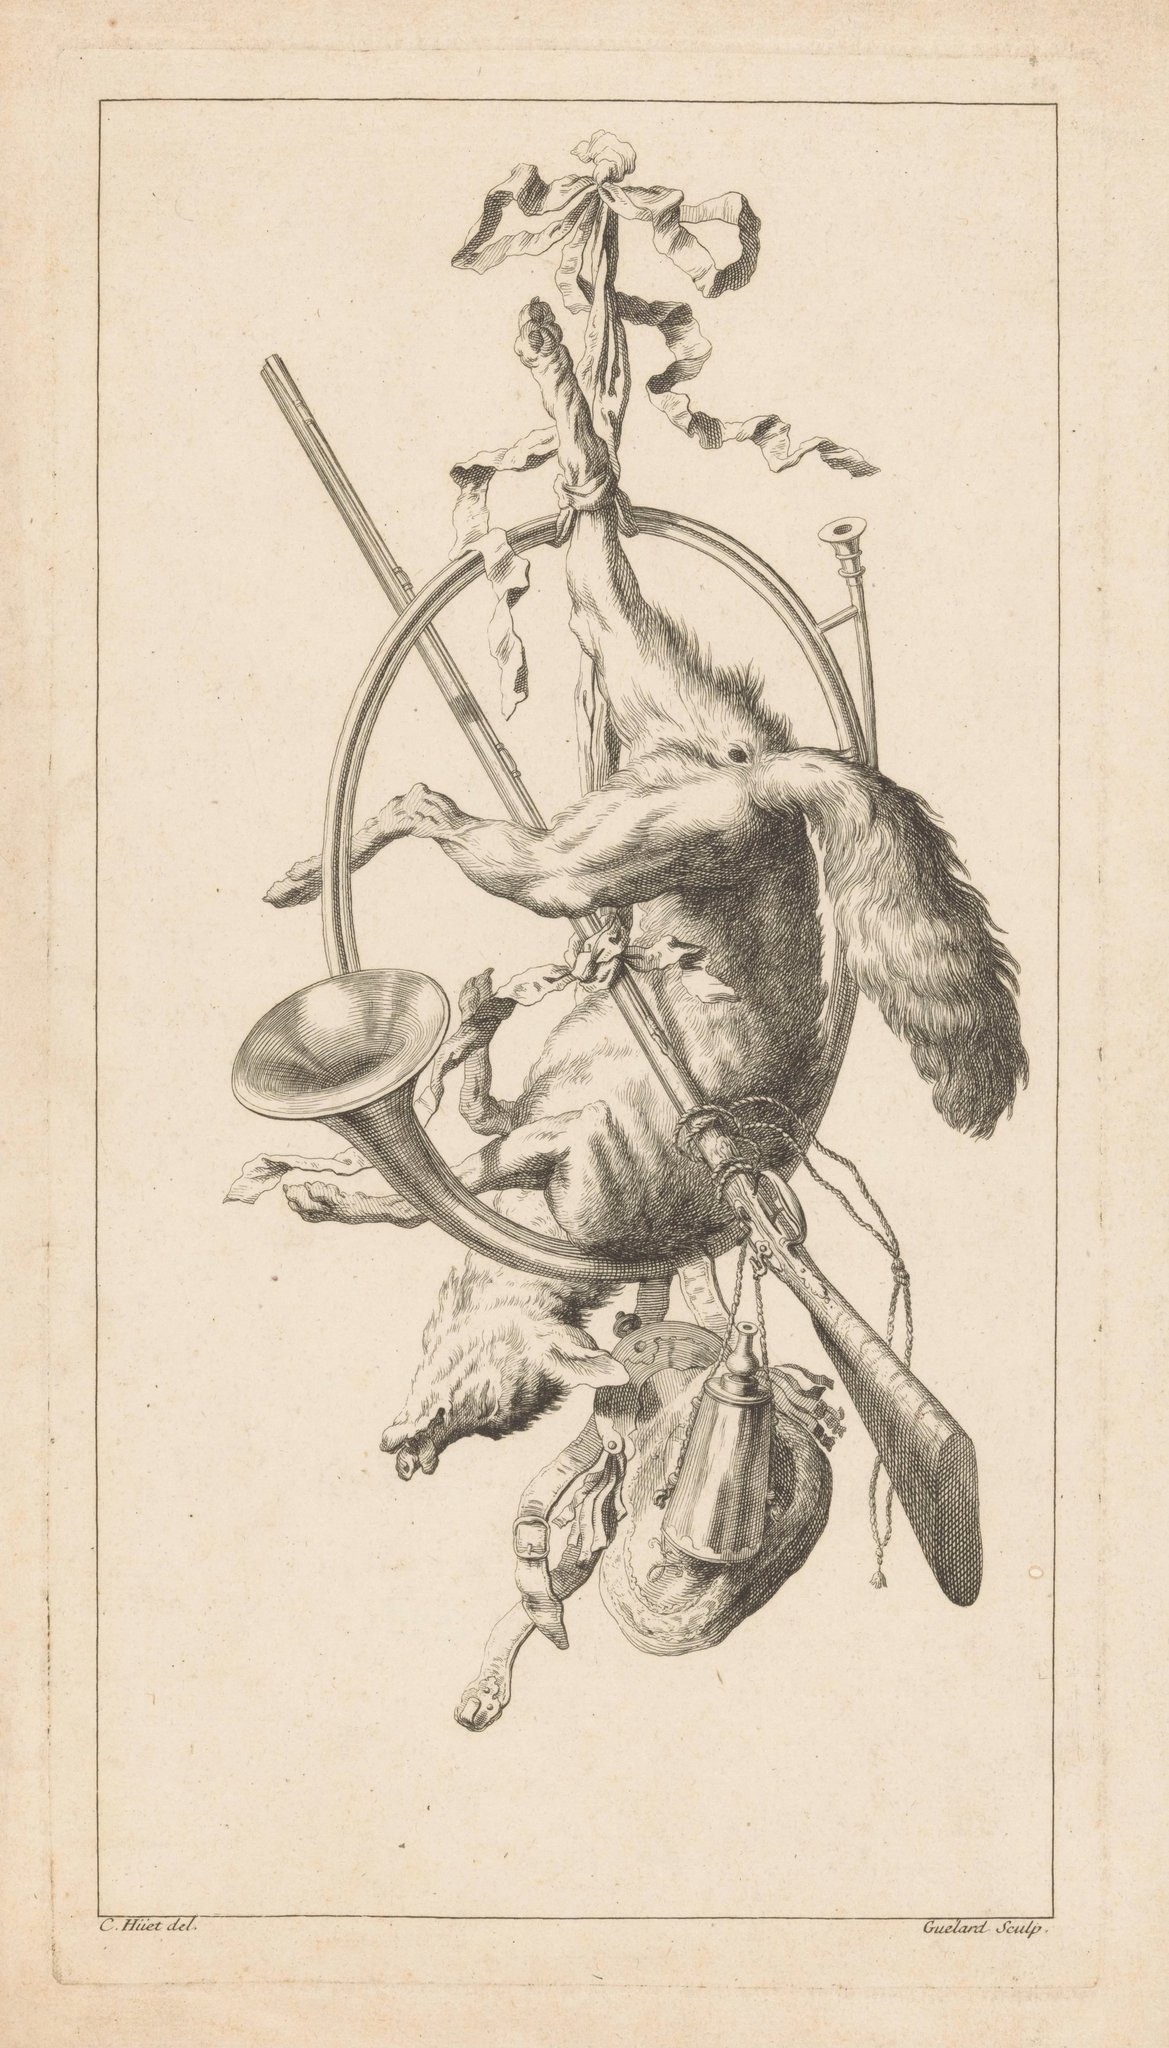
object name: ornament print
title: Trofee met vos en jachthoorn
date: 1733-1748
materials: paper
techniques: engraving, etching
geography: paris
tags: hunting horn, hunting trophies, beasts of prey, predatory animals: fox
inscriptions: collector's mark: Lugt 2228, collector's mark: Lugt 2760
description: Een jachttrofee met een vos, een geweer, een jachthoorn, een fles en een tas.